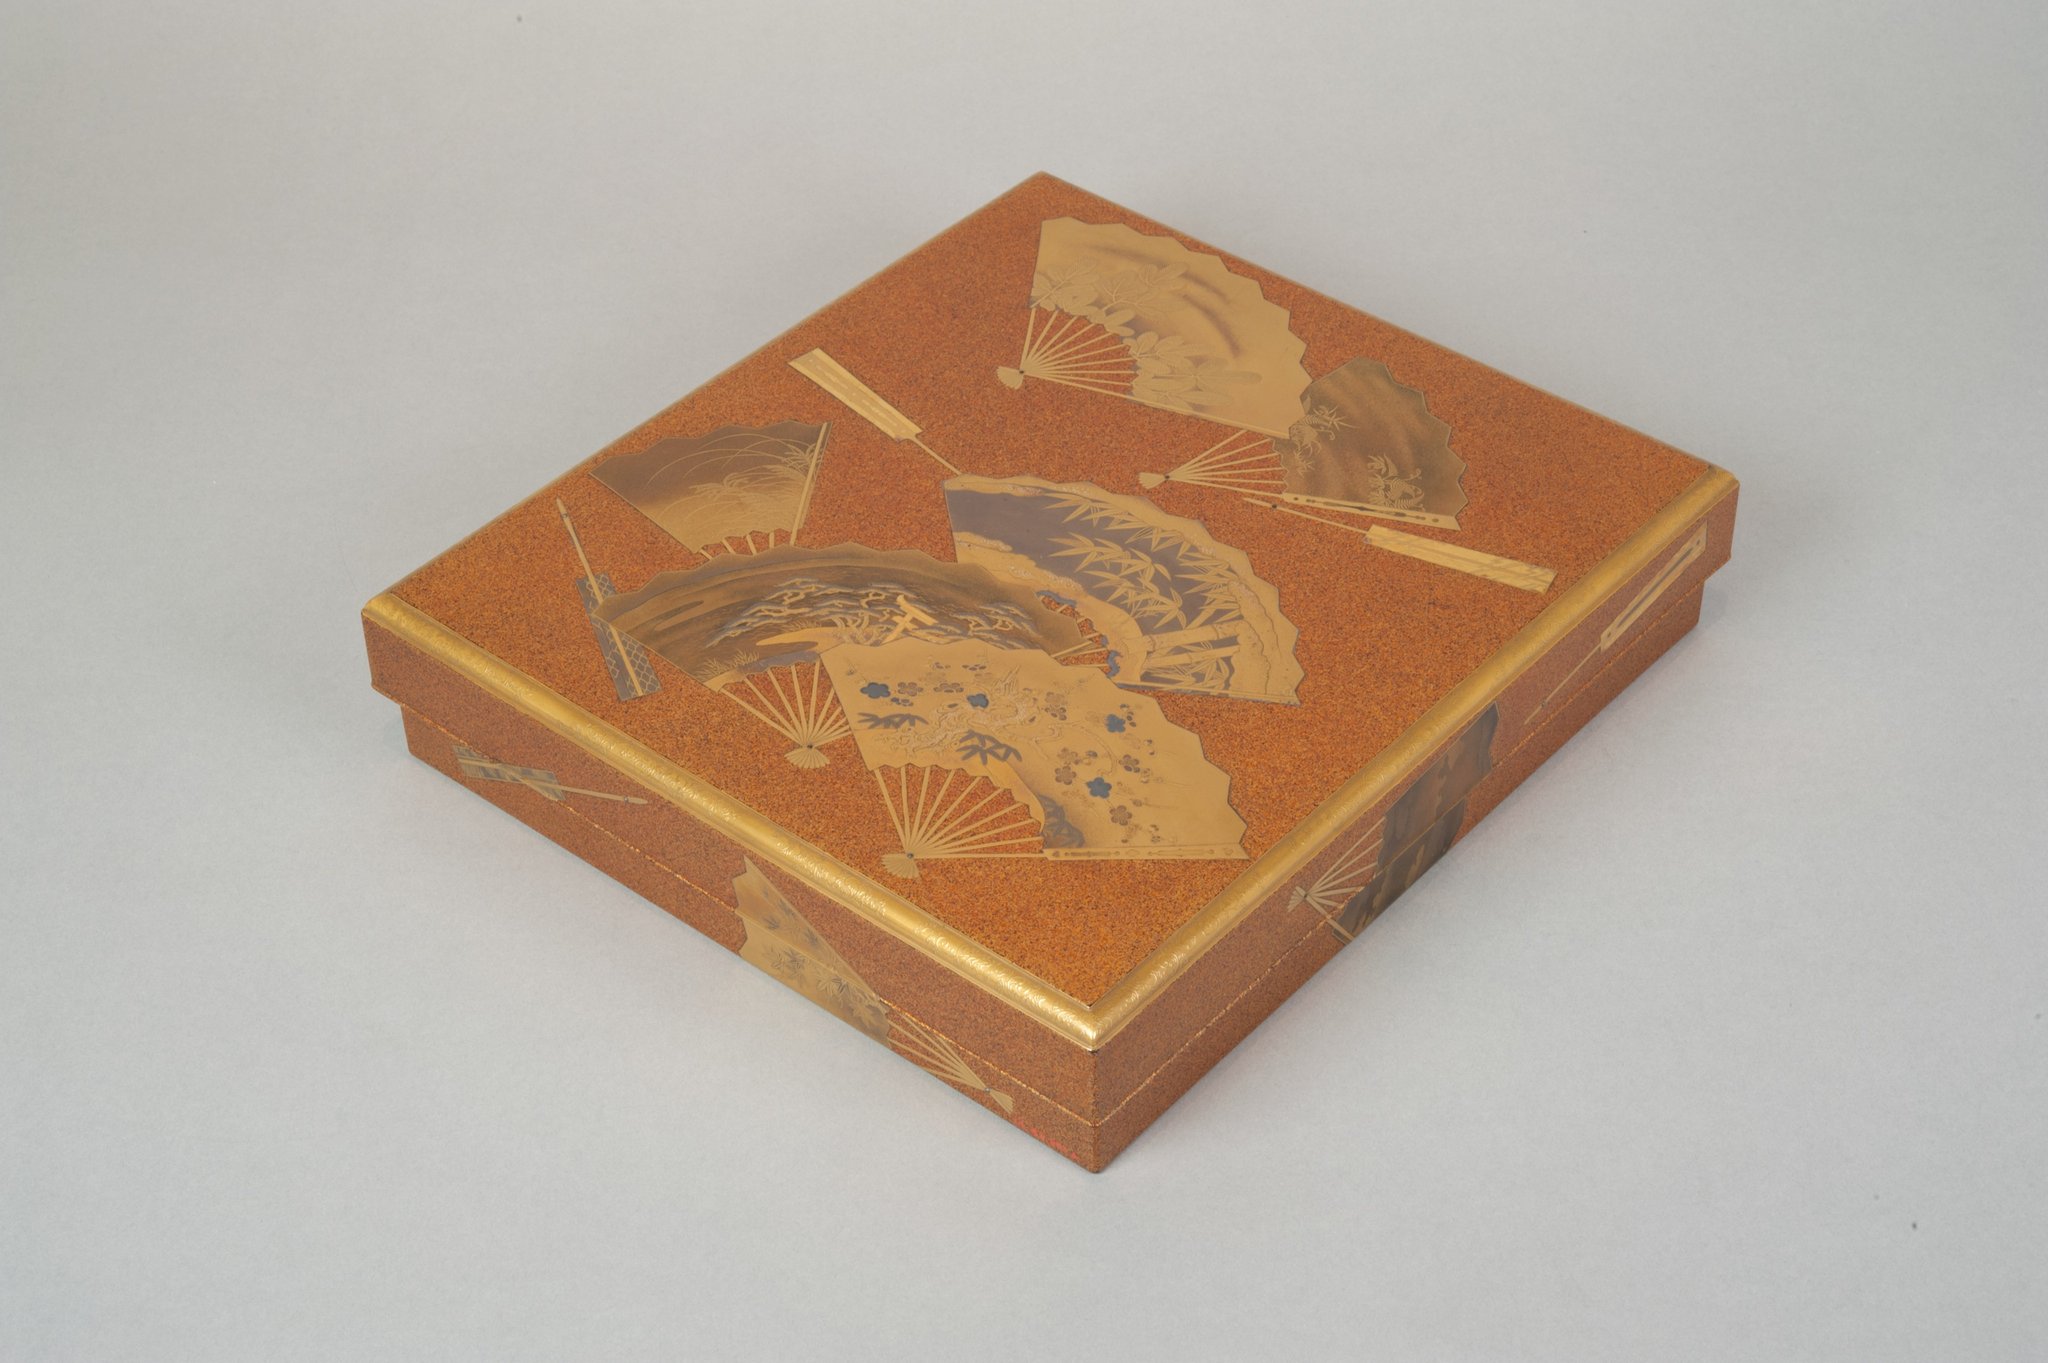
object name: writing box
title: Writing Box (Suzuribako) with Design of Fans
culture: japanese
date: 1601-1700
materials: gold, lacquer, silver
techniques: maki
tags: fans